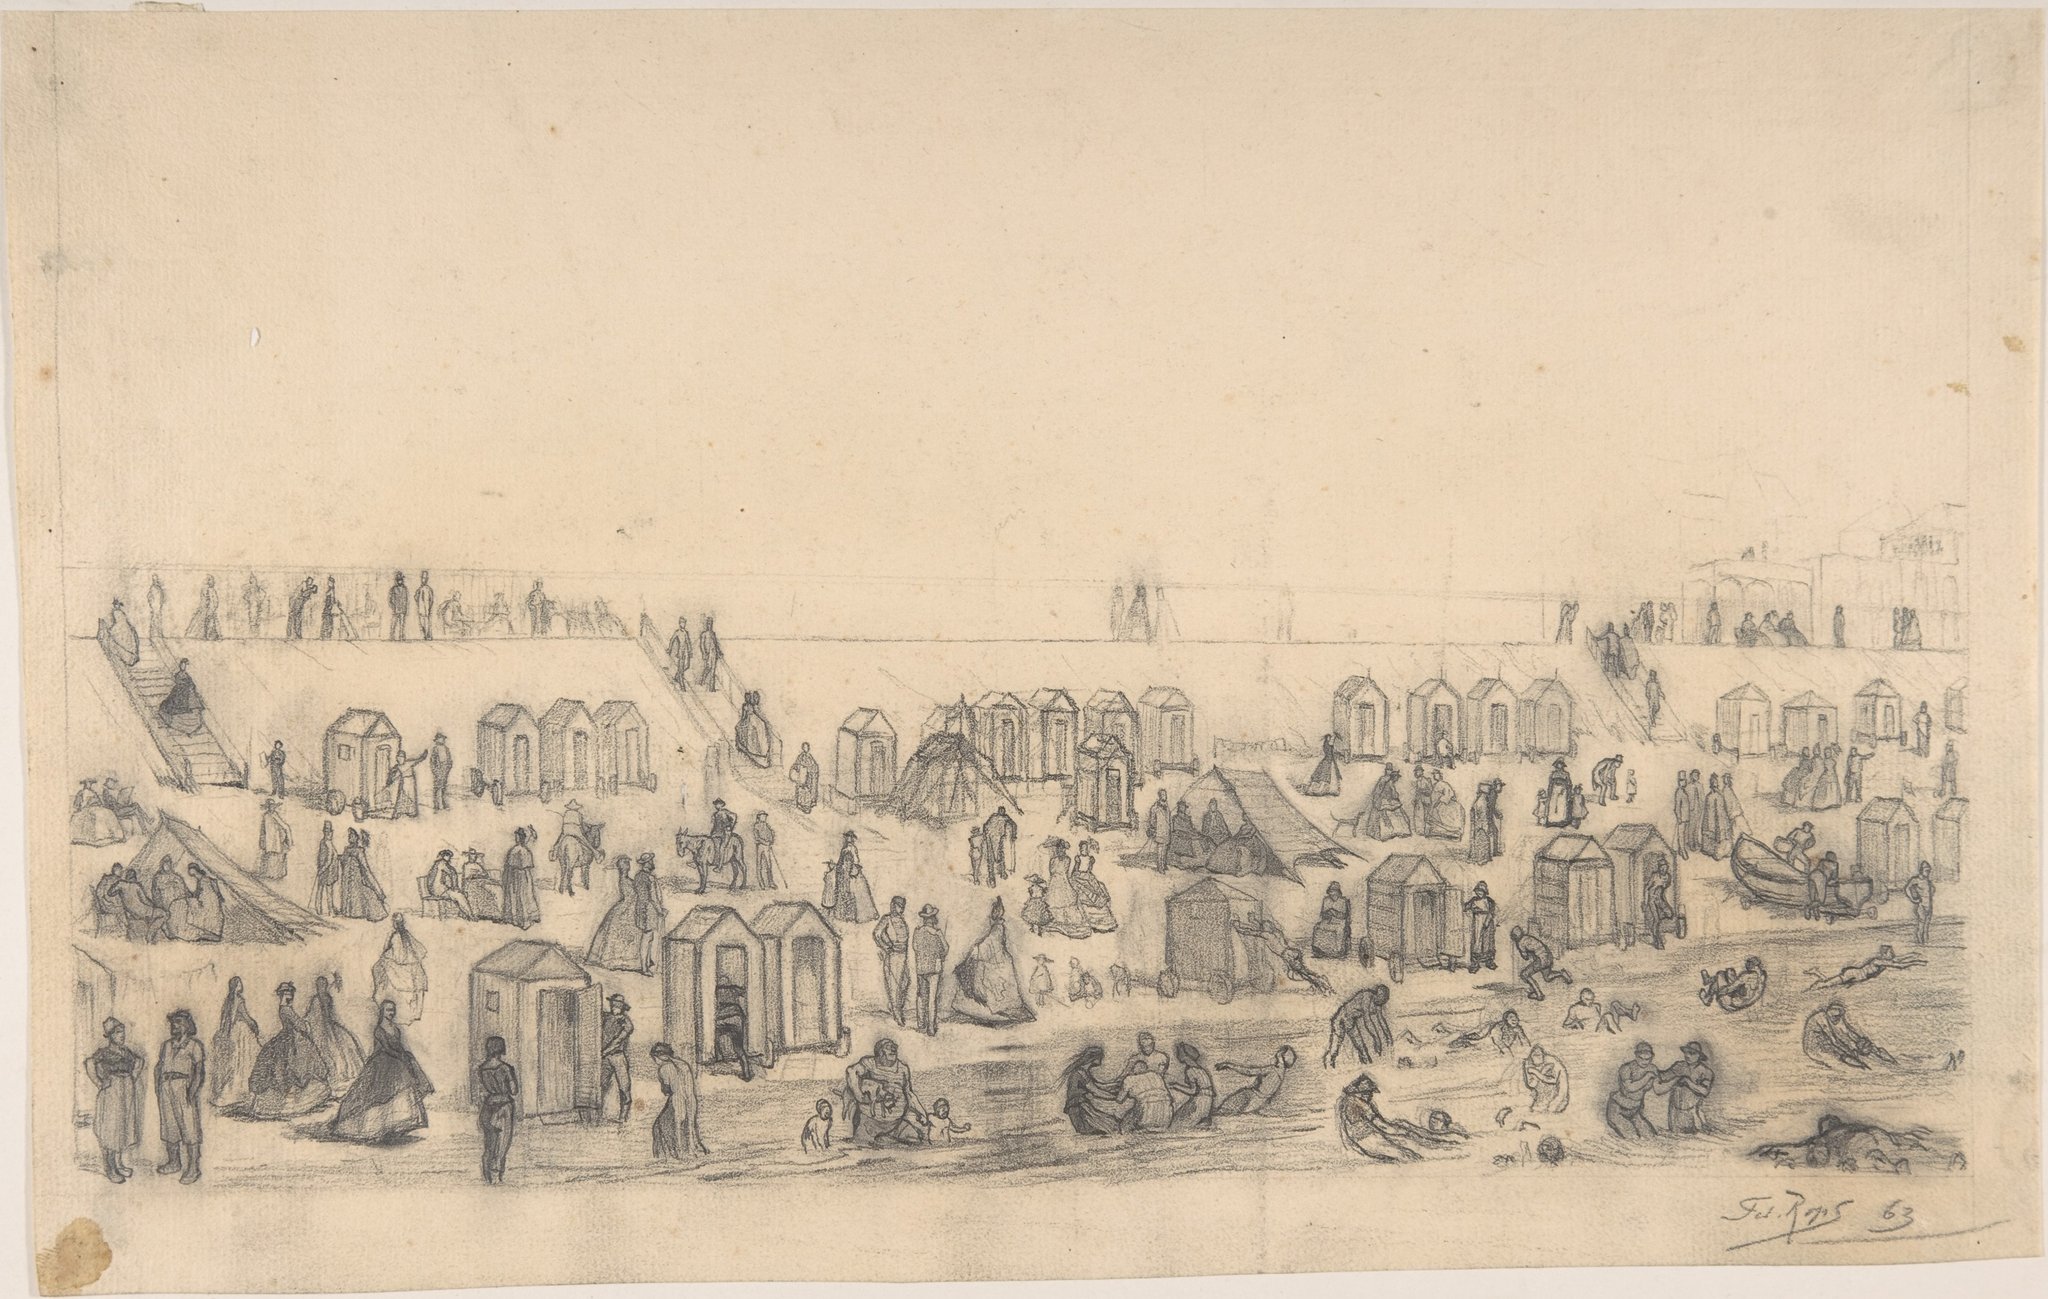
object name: drawing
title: The Beach at Blankenberghe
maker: félicien rops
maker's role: artist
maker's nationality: belgian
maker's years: 1833-1898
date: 1863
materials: graphite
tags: human figures,tents,seas,beaches,bathing